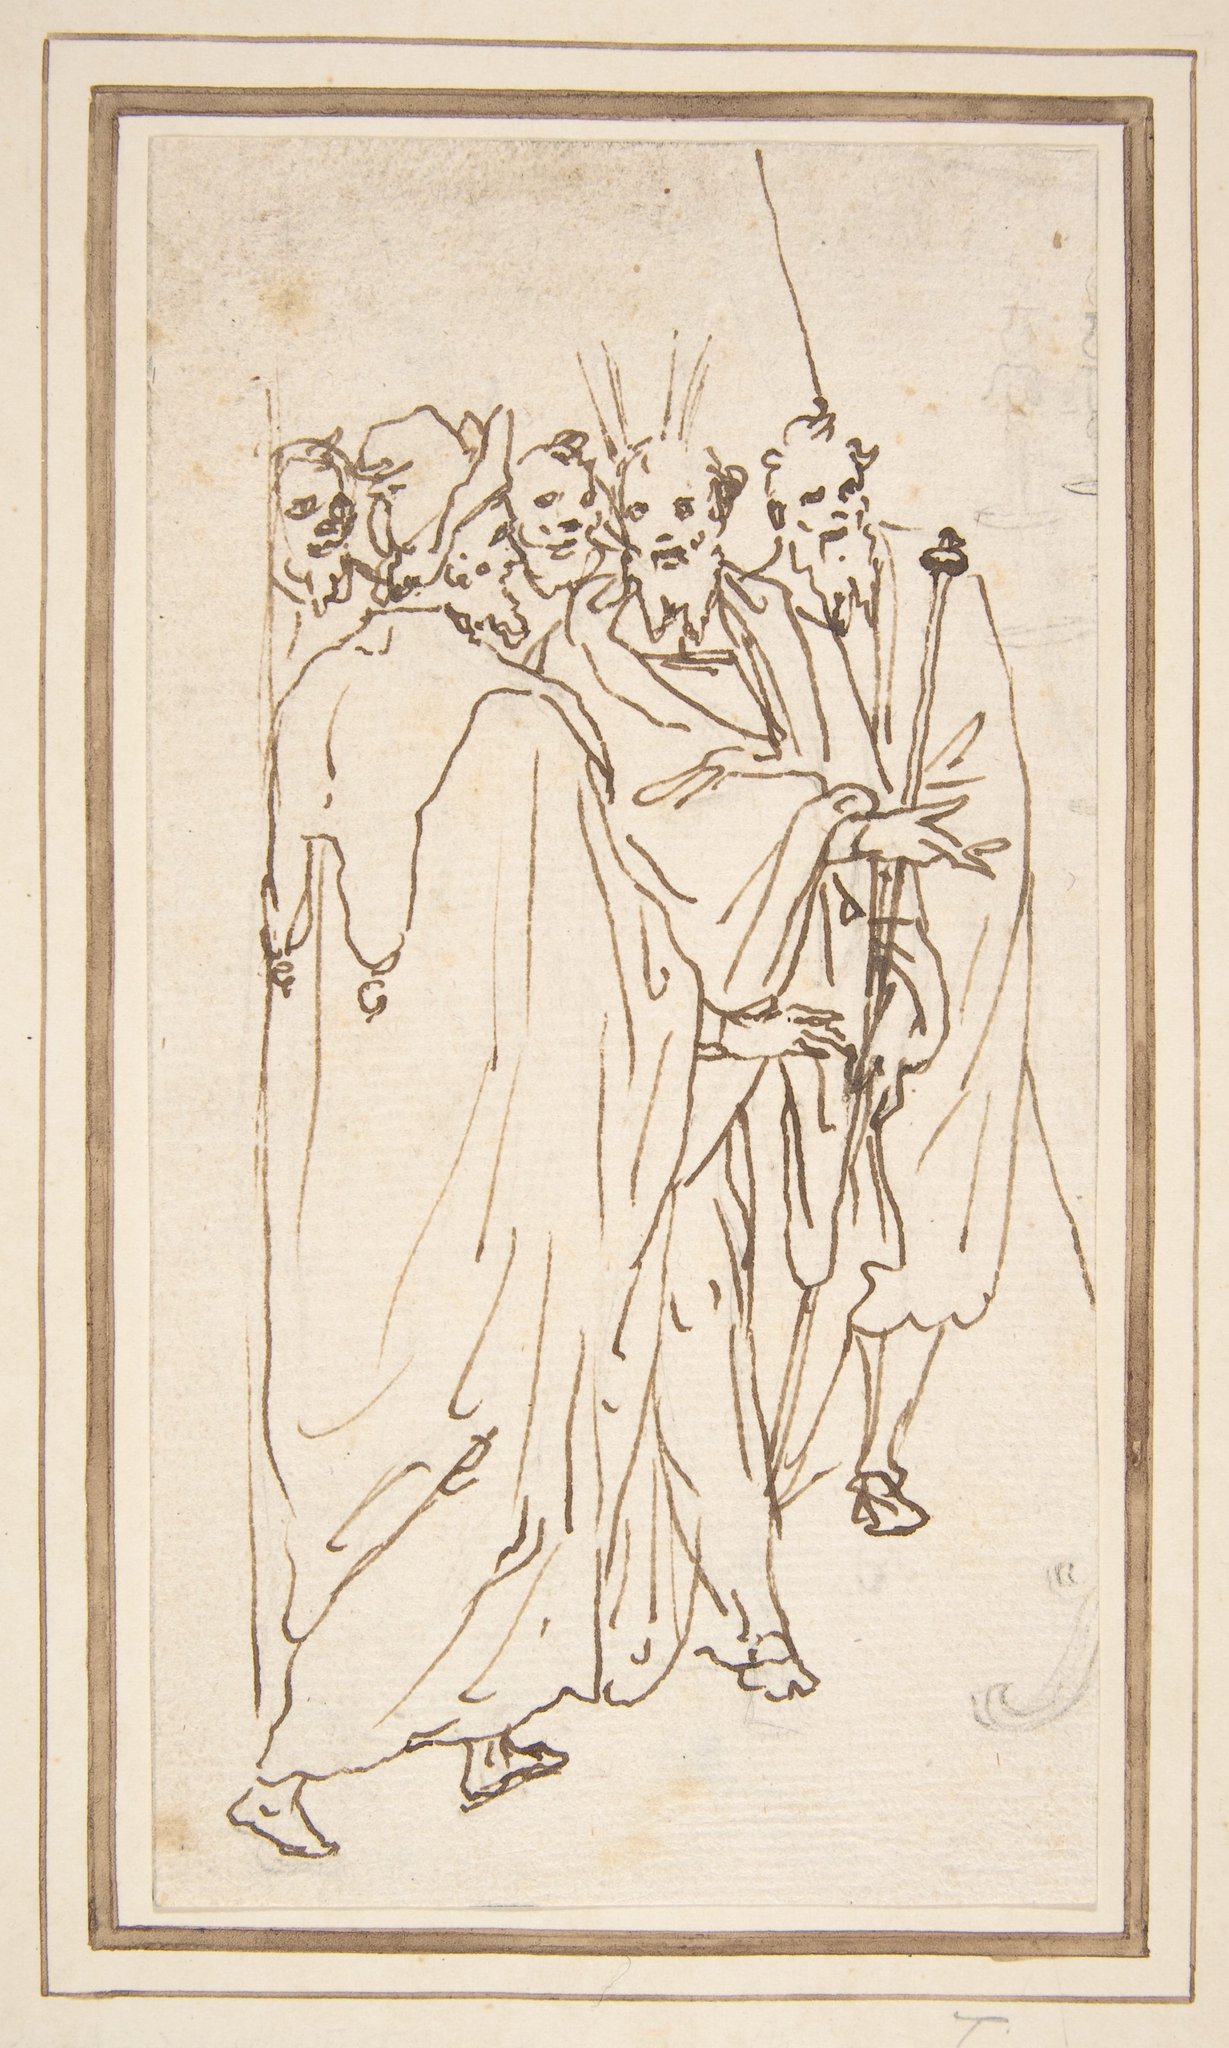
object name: drawing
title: Moses and Other Figures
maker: cesare nebbia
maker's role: artist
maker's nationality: italian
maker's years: 1536-1614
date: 1570-1580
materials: chalk, ink, drawing material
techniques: pen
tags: men,moses